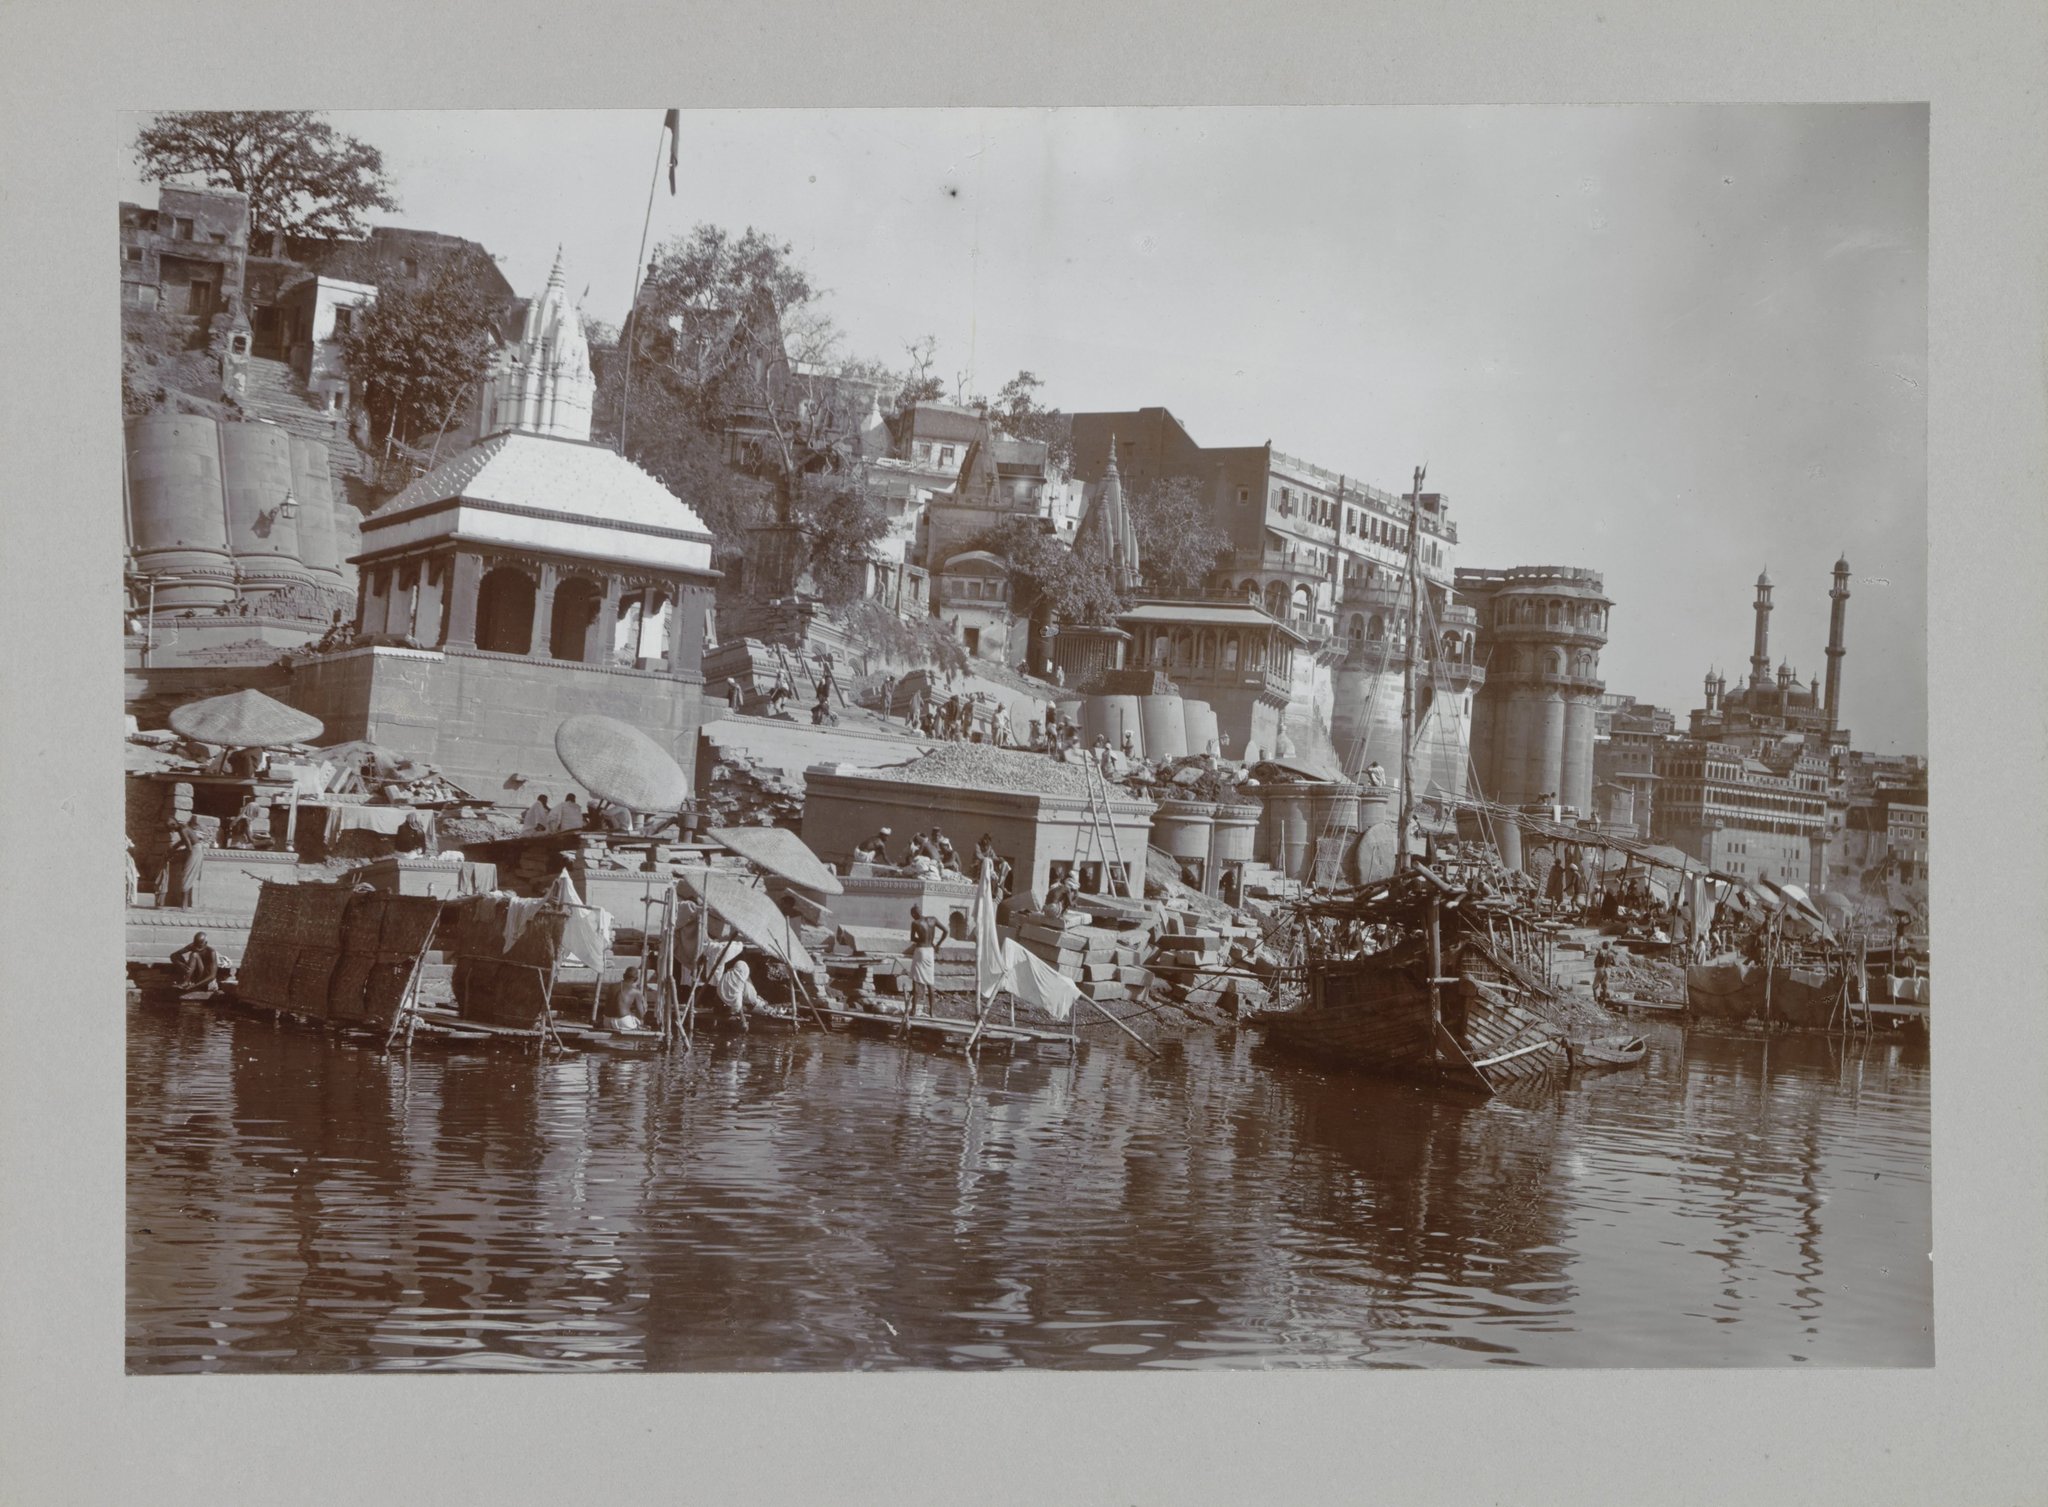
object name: photograph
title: View of the Ganga river at Varanasi, Uttar Pradesh, India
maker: Anonymous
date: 1895-1915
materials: cardboard, paper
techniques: gelatin silver print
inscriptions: annotation: ‘10. Benares.’